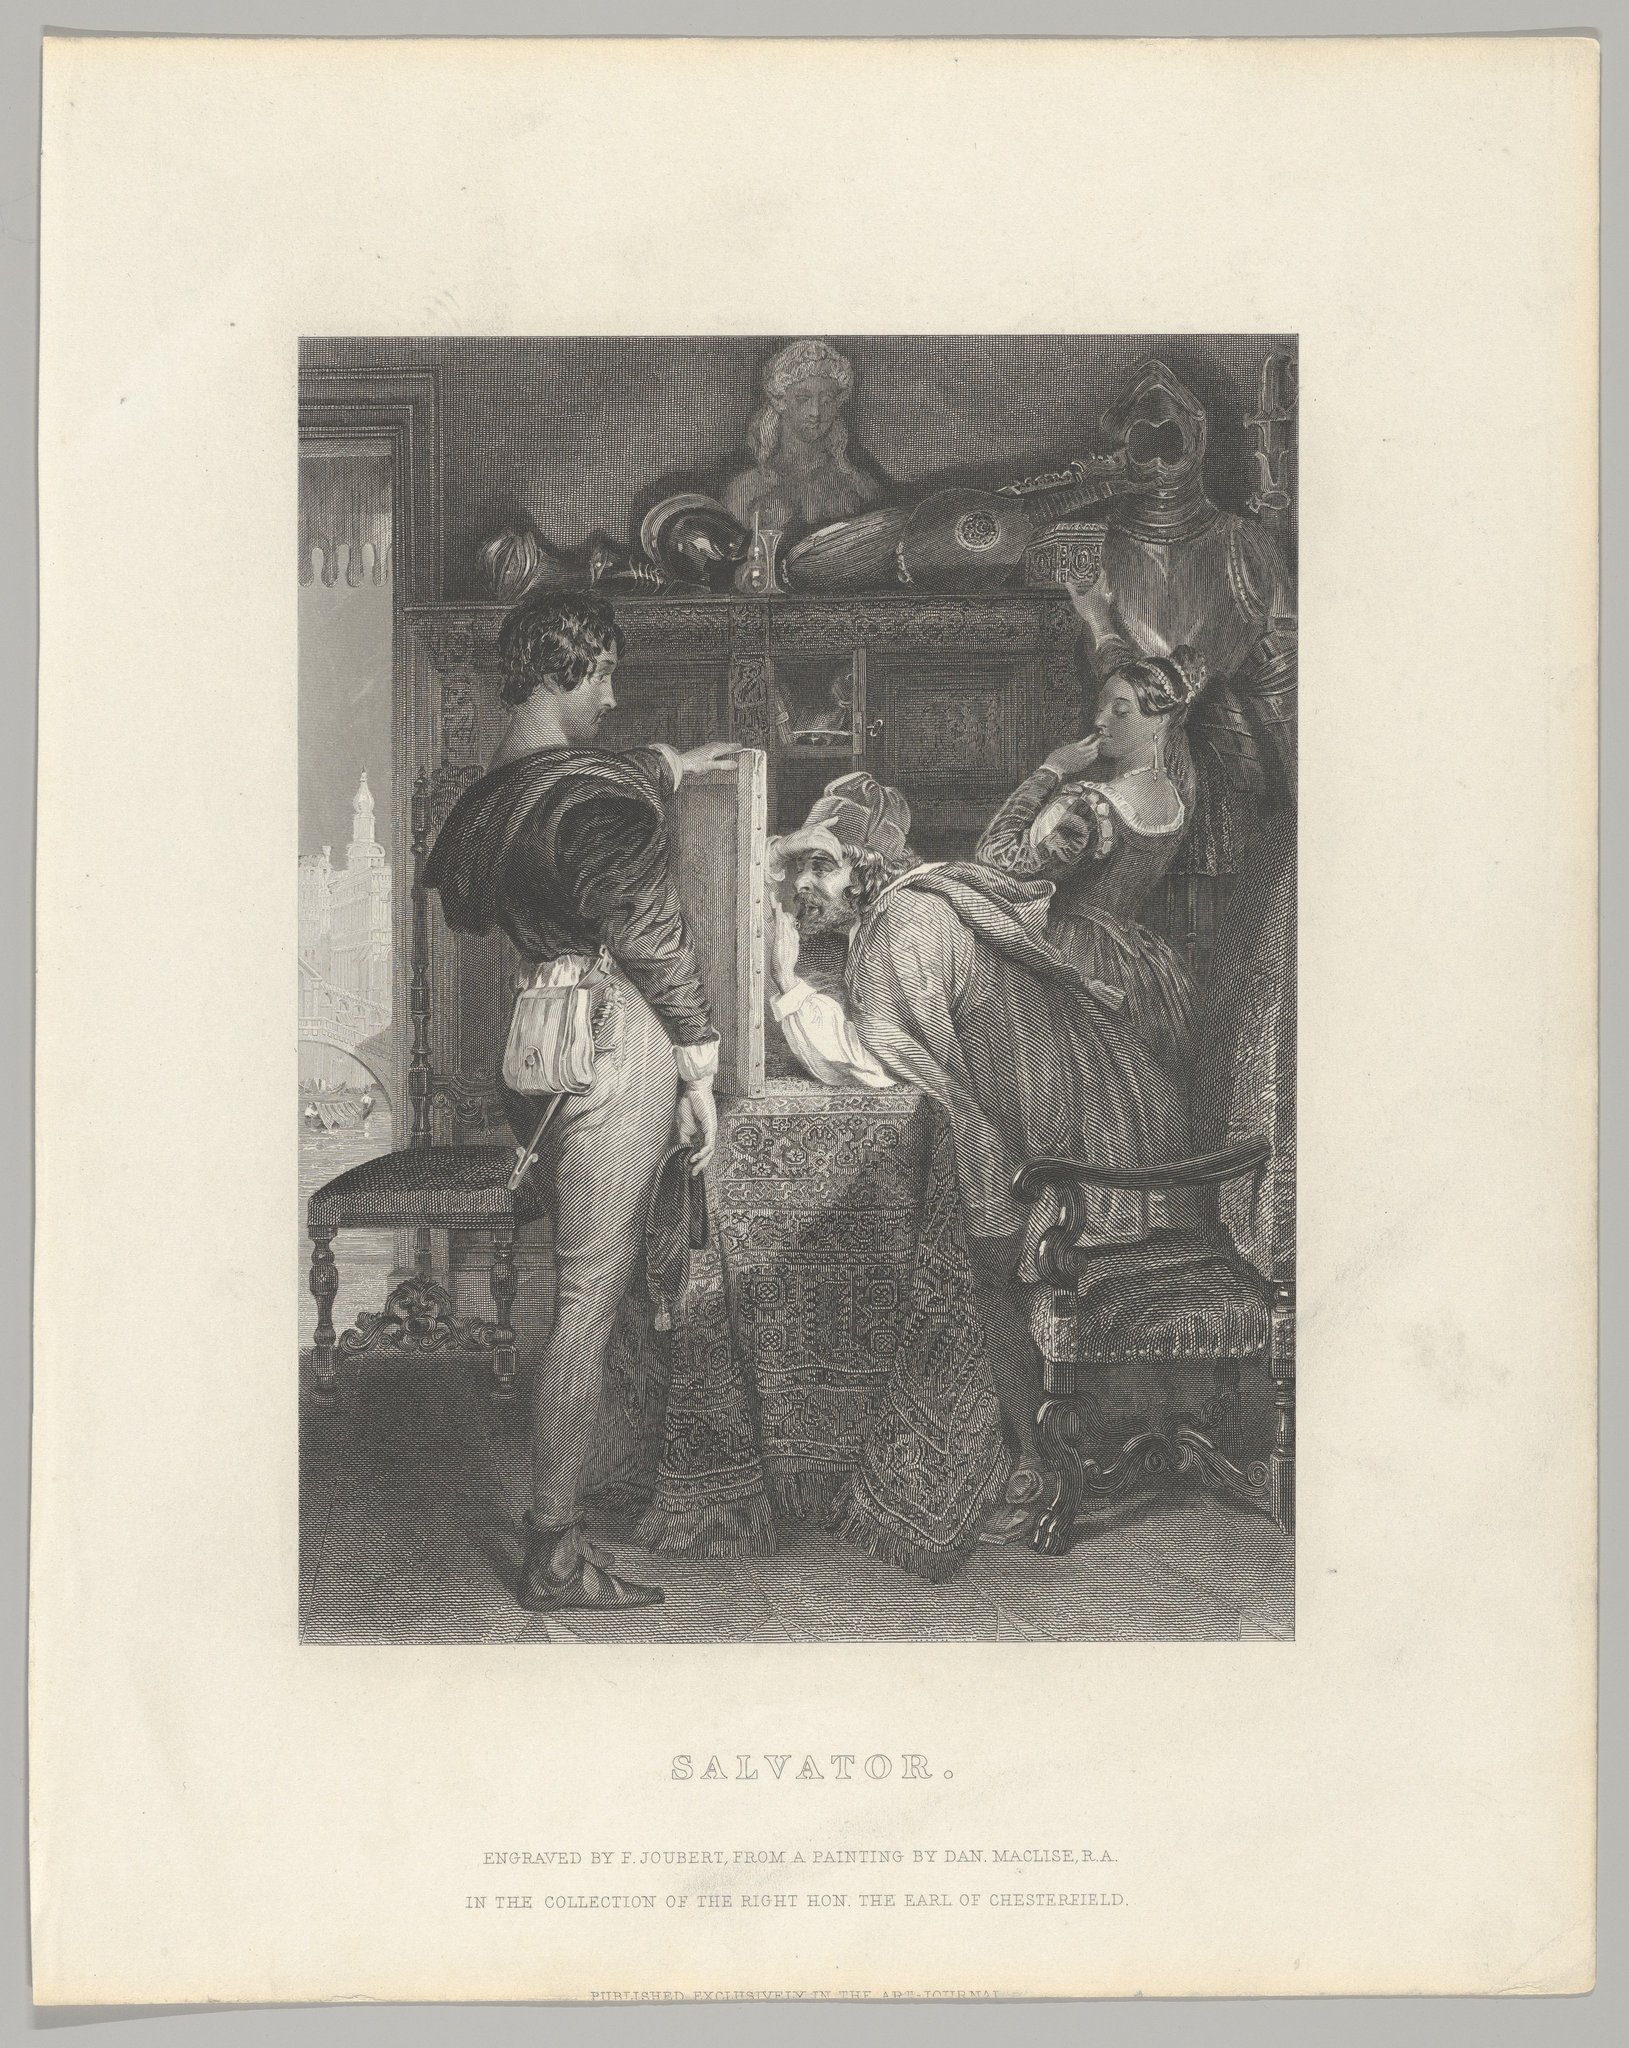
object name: print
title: Salvator, from "The Art Union" (later "The Art Journal"), opposite p. 252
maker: ferdinand joubert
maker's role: engraver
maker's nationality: french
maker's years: 1810-1884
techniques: engraving, etching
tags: men,women